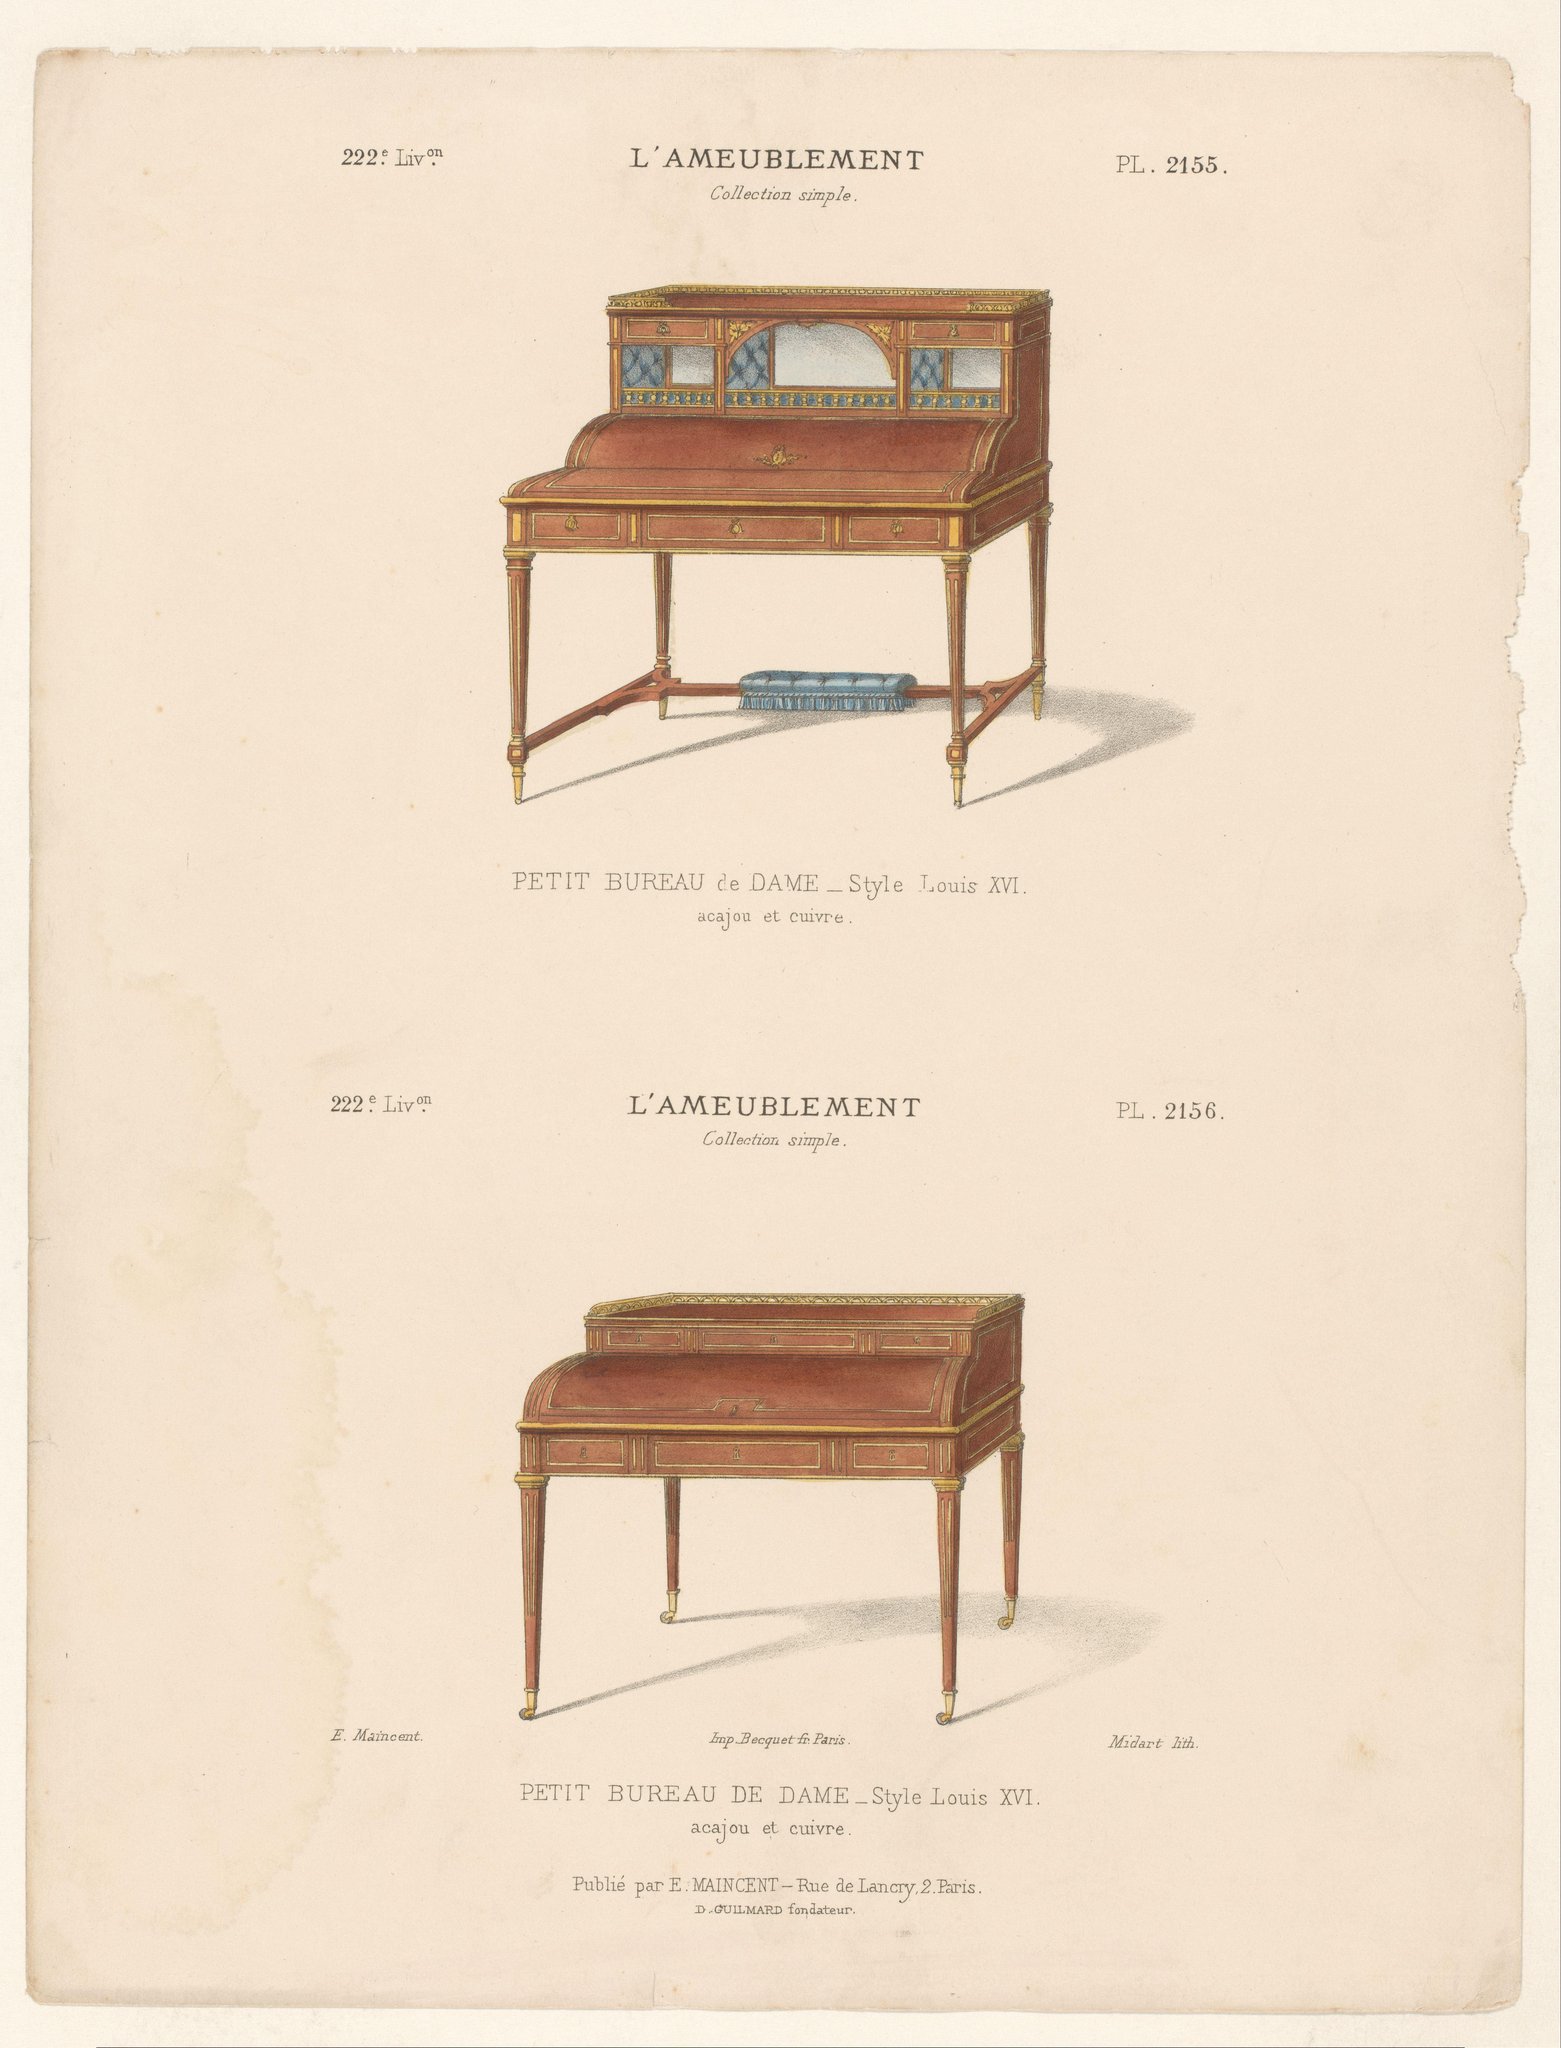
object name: print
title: L'ameublement / Collection simple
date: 1885-1895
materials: paper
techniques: hand coloring, lithograph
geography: paris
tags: writing-table, writing-desk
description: Twee damesbureaus in de Lodewijk XVI-stijl. Prent uit 222e Livraison.